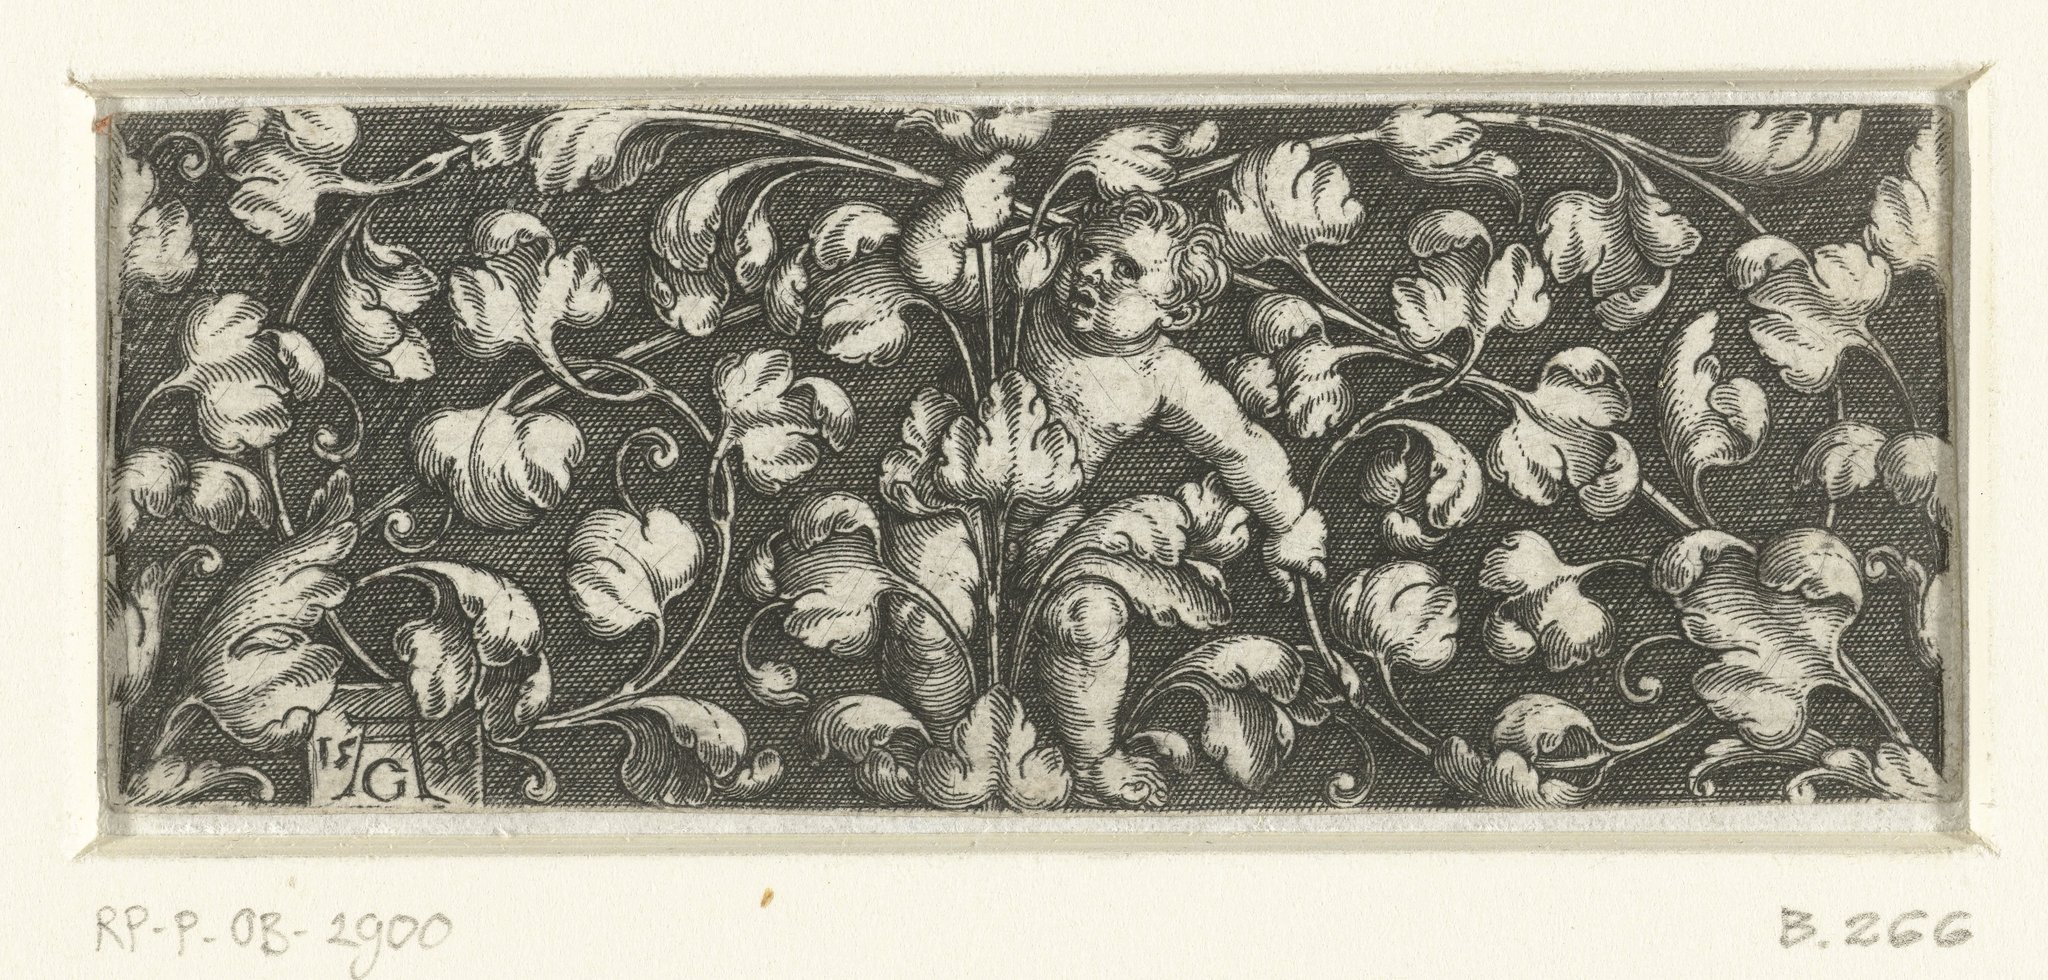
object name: ornament print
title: Fries met bladranken en een kind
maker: heinrich aldegrever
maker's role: draughtsman, print maker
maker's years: 1502-1561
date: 1539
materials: paper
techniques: engraving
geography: germany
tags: foliage, tendrils, branches ~ ornament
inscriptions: date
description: Fries met bladranken, achter de stengel in het midden zit een kind.